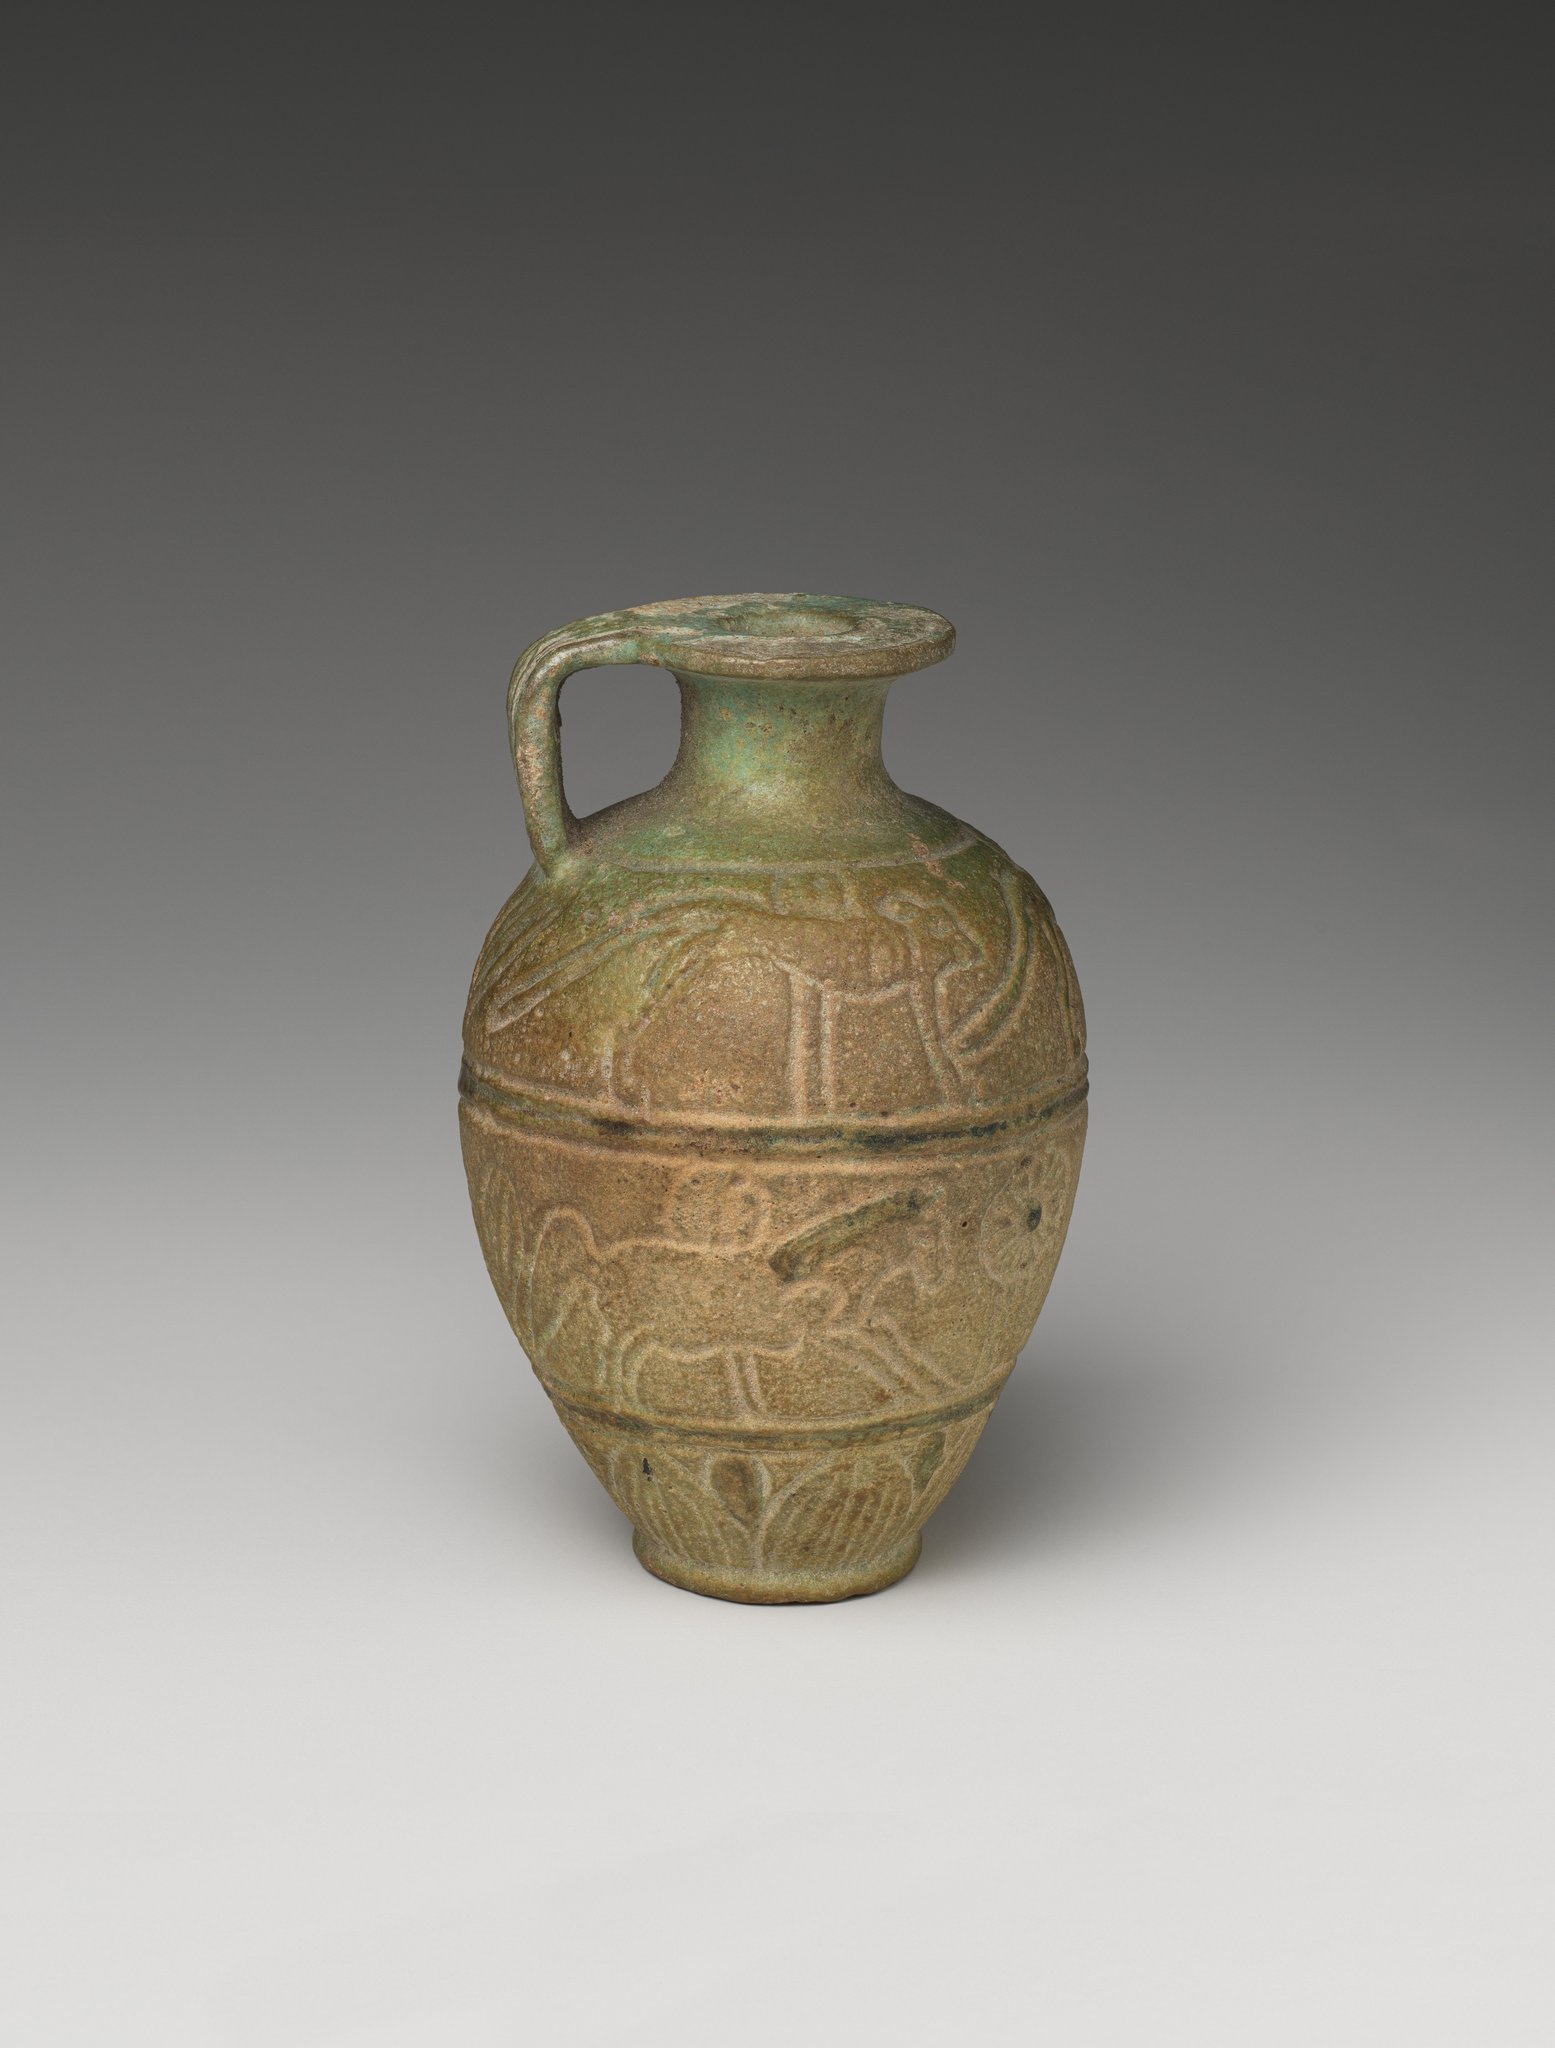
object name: jug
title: Aryballos (perfume vase) with two registers of animals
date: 700-601 BCE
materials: faience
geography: egypt